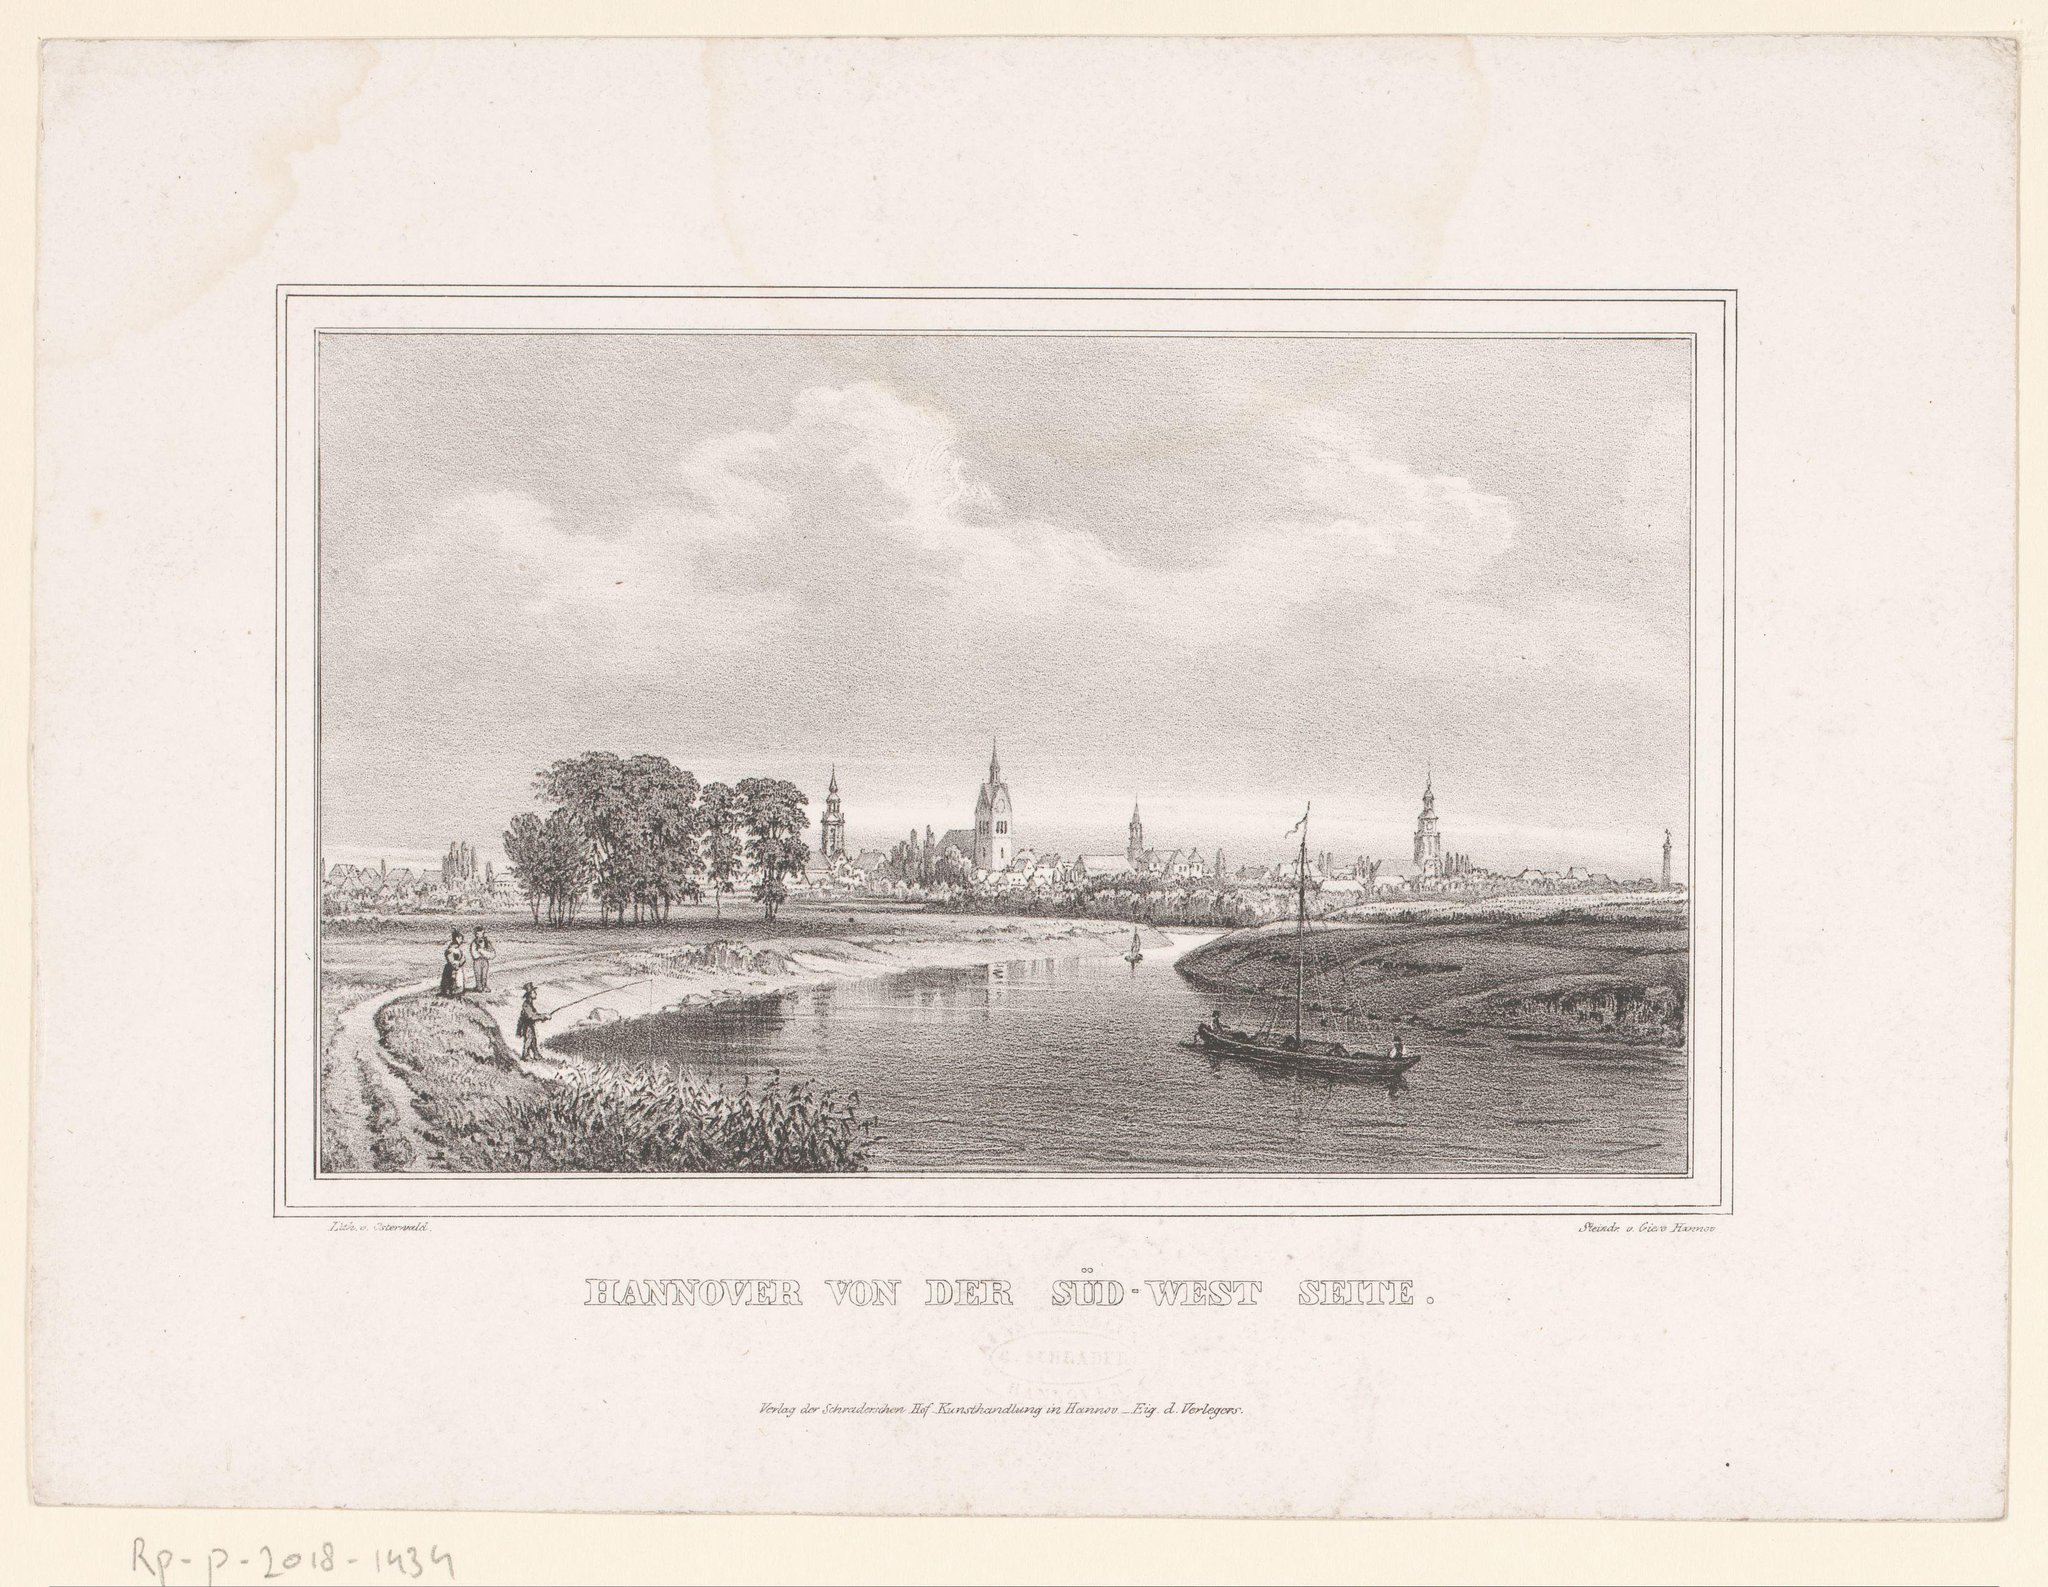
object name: print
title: Hannover von der süd-west seite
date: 1832-1845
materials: paper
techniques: lithograph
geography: hannover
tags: prospect of city, town panorama, silhouette of city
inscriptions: check stamp: ‘C. Schrader. Kunst Handlung Hannover’